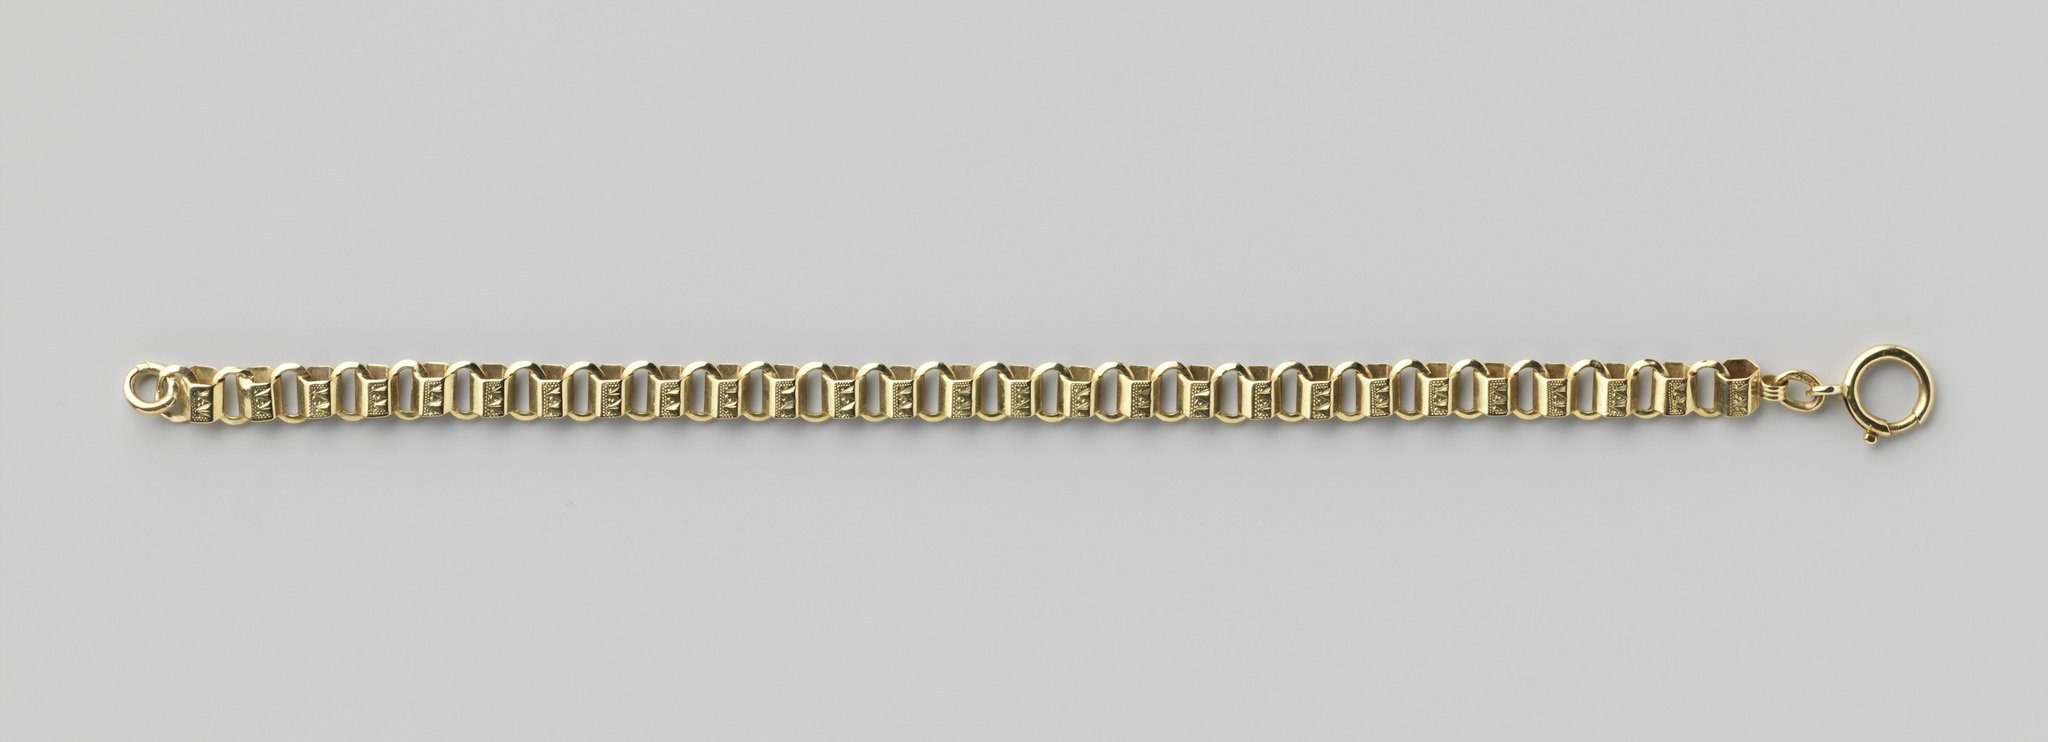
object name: chain bracelet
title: Schakelarmband van goud met Emmaschakel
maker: Anonymous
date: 1910-1920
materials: gold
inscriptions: alloy mark: ‘(oud) eikenblad’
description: Schakelarmband van goud met Emmaschakel. De armband sluit met een veerring.